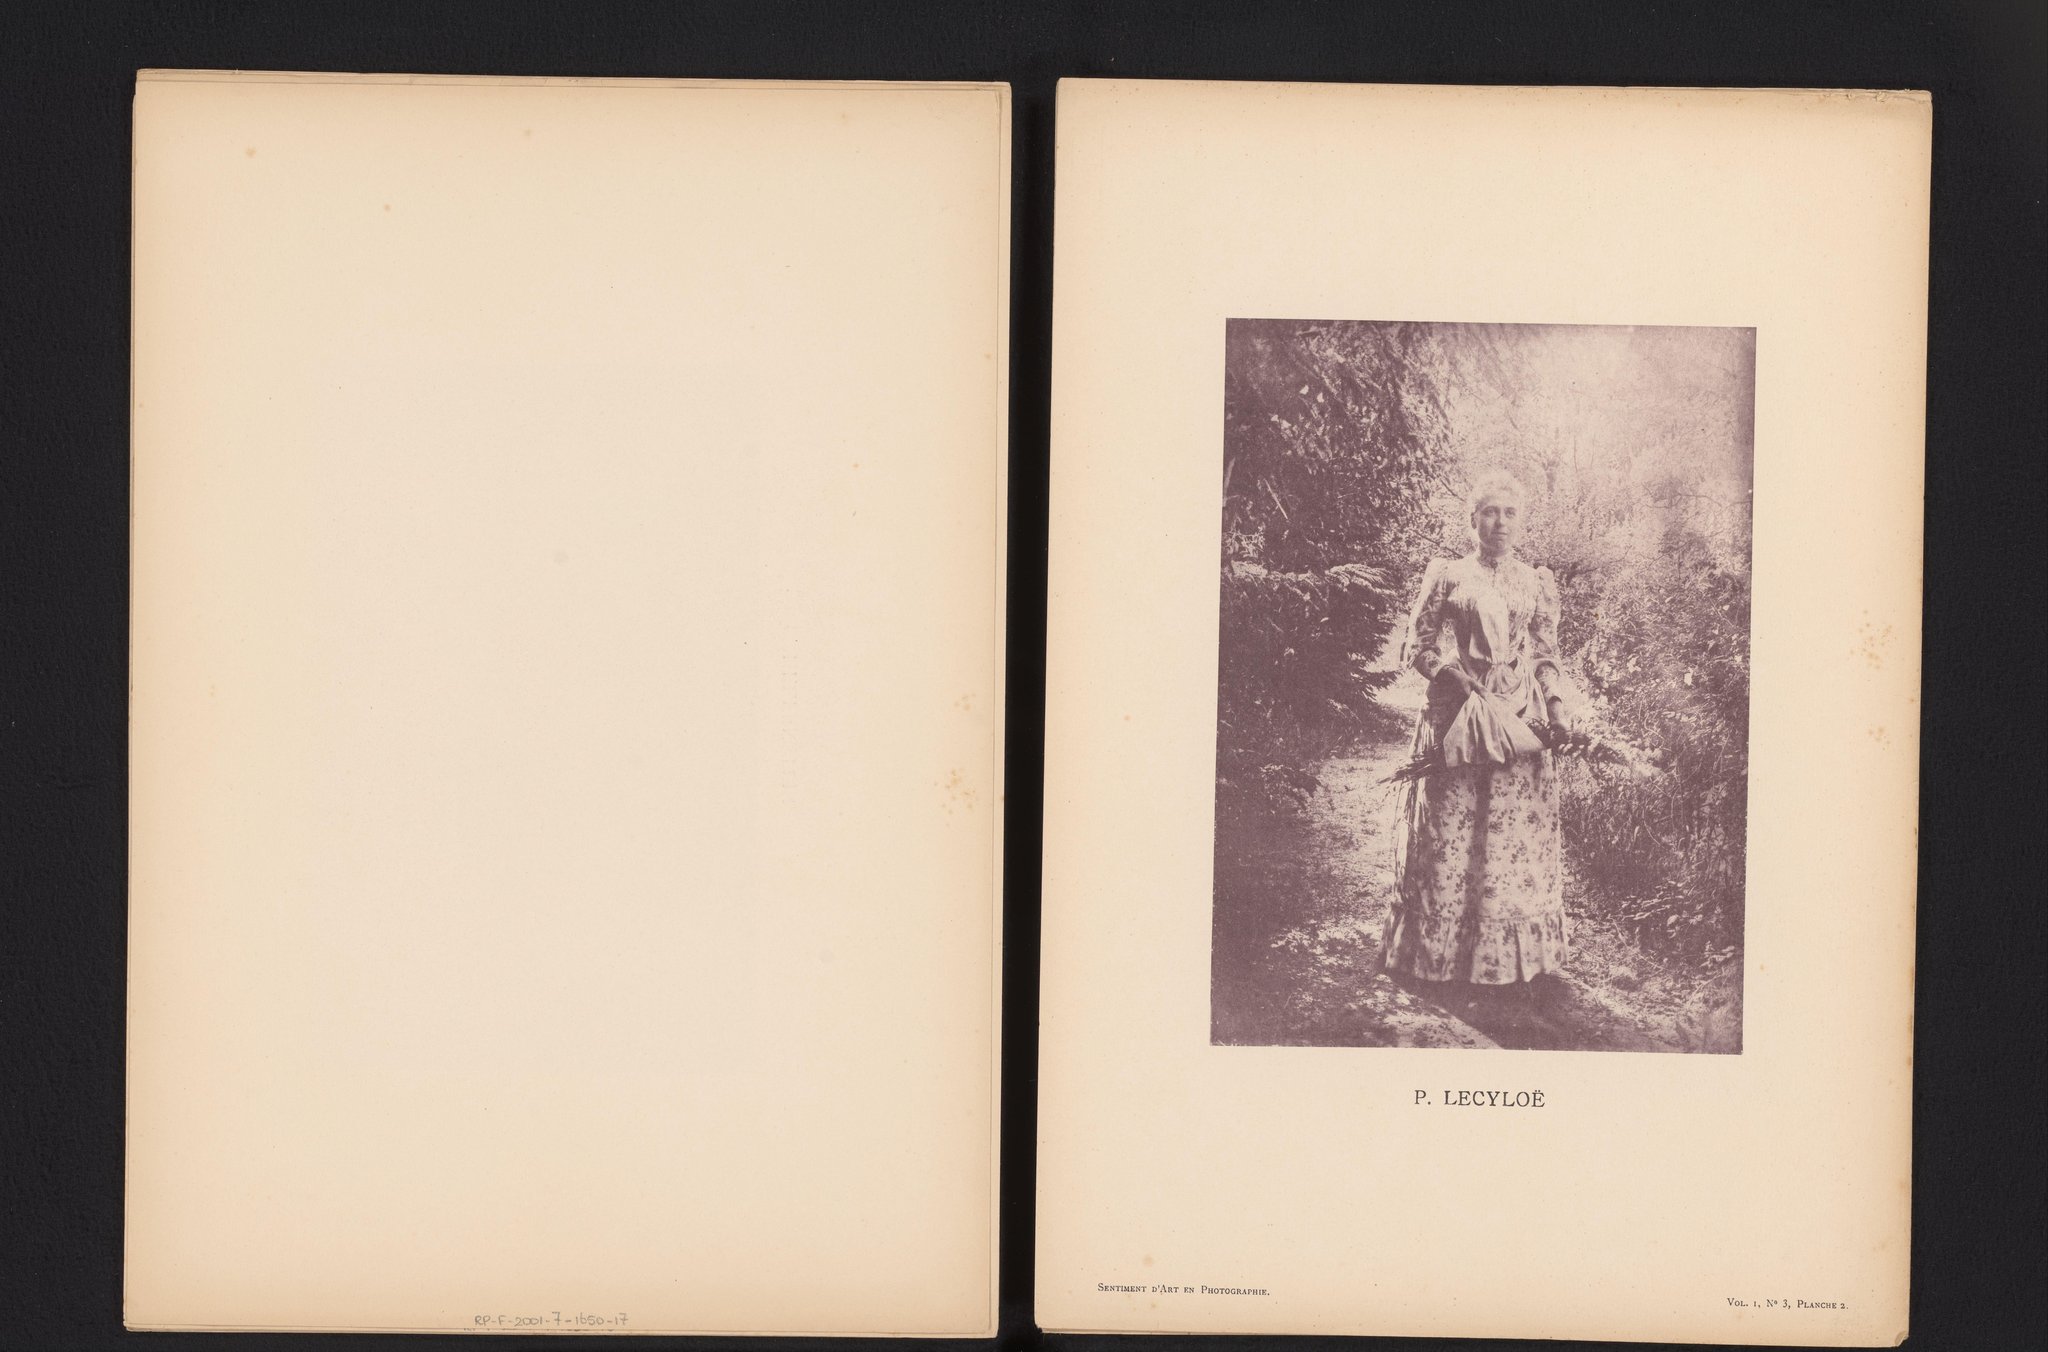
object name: photomechanical print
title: Sentiment d'Art en Photographie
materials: paper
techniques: photograph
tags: historical persons - bb - woman, forest, wood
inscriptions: number: ‘Vol. 1, No 3, Planche 2.’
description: Deze prent maakt deel uit van 8 omslagen met 22 tekstbladen en 89 prenten op losse bladen in en tussen de omslagen.